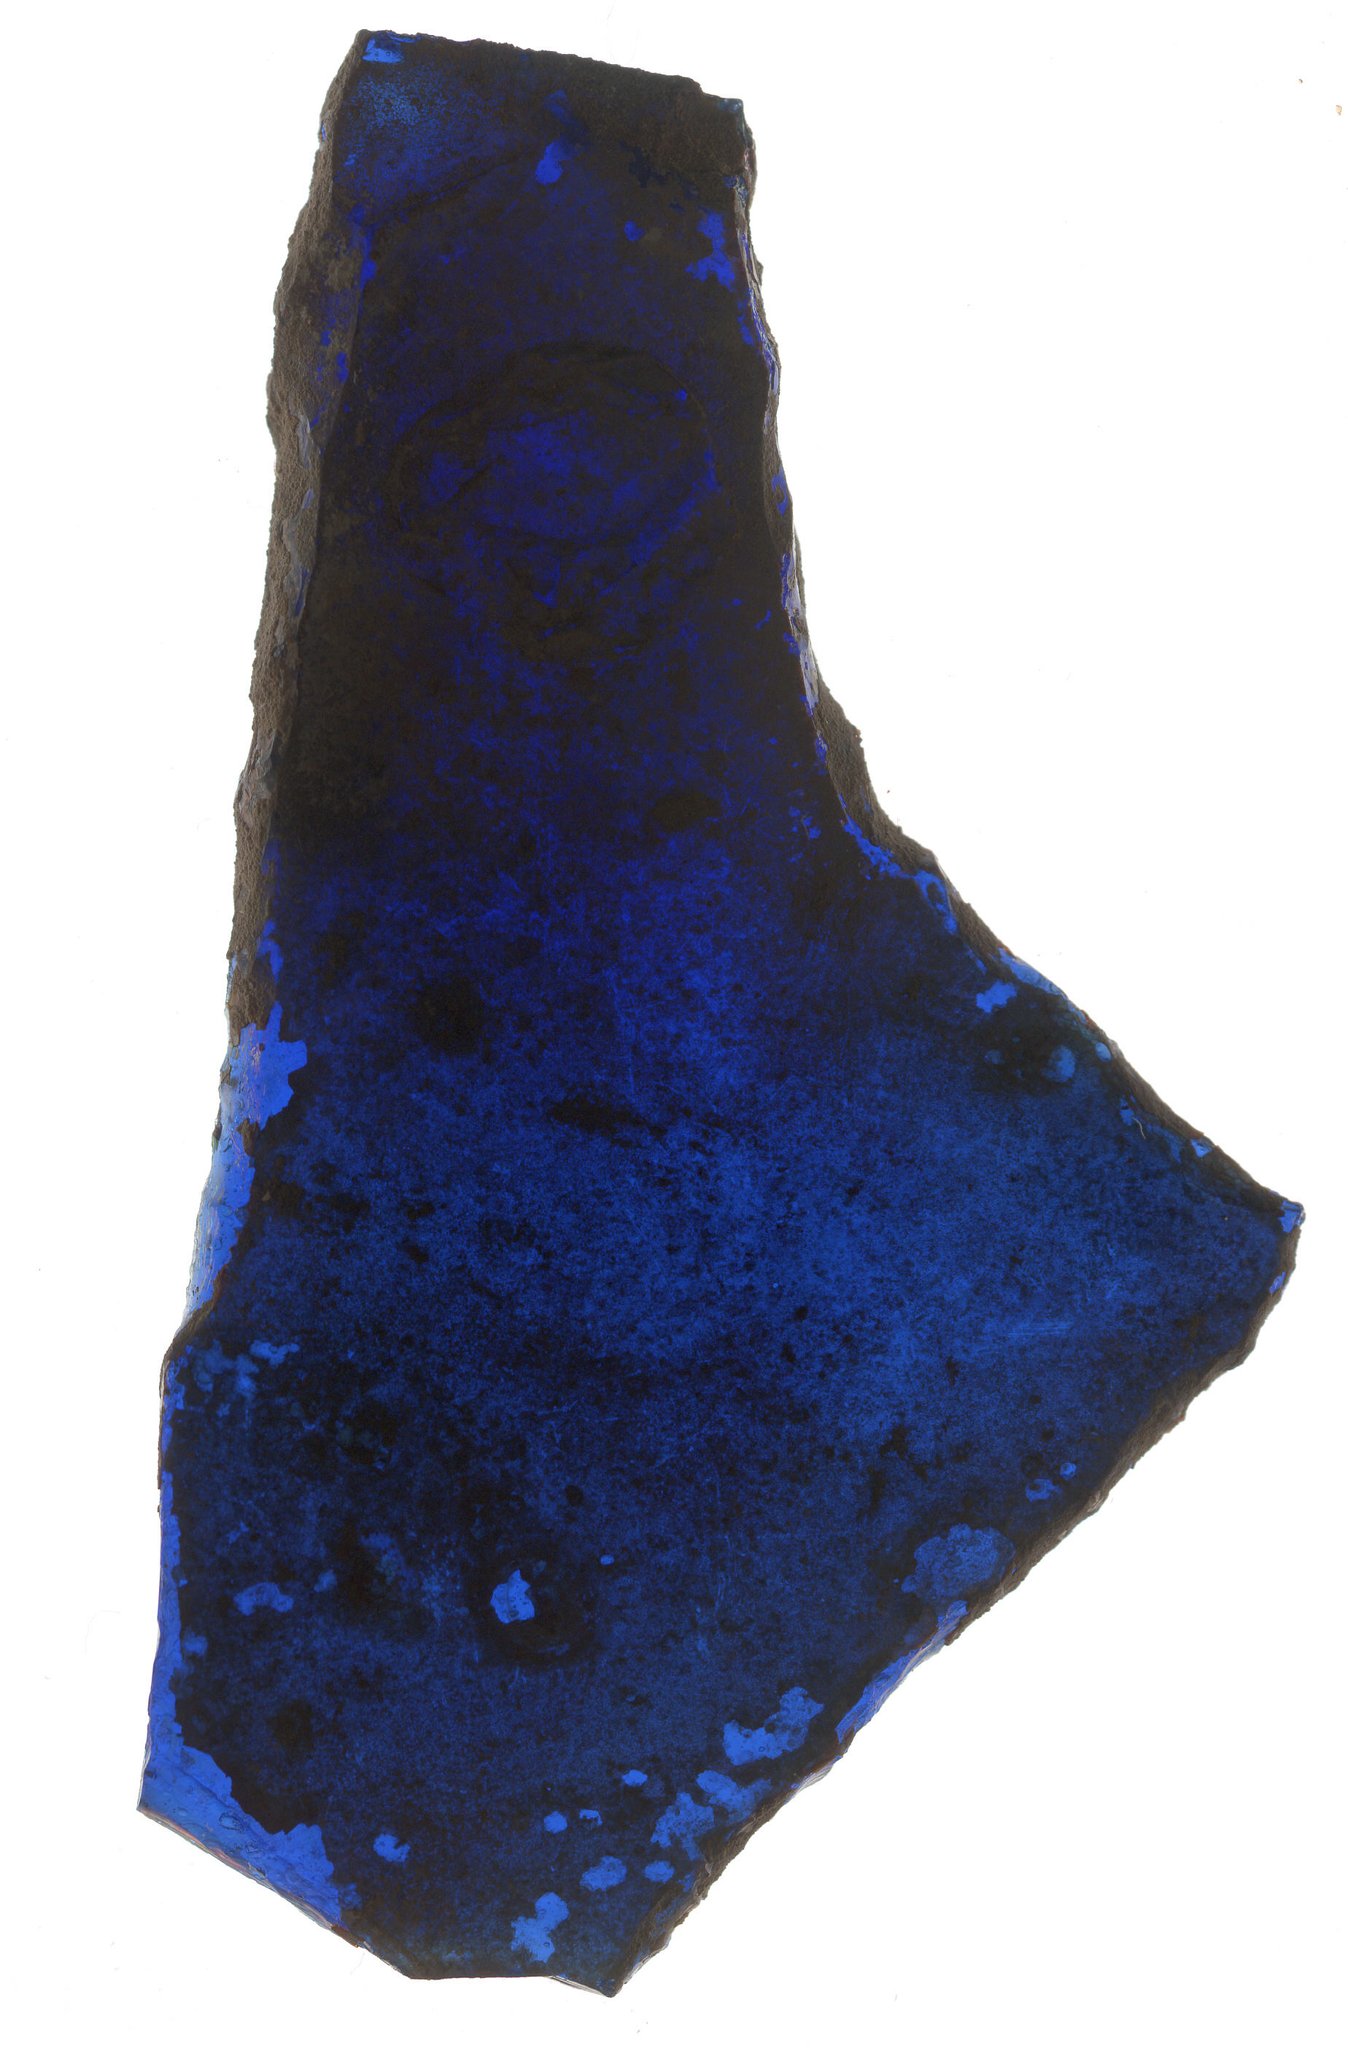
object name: fragment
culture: crusader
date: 1201-1300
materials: glass